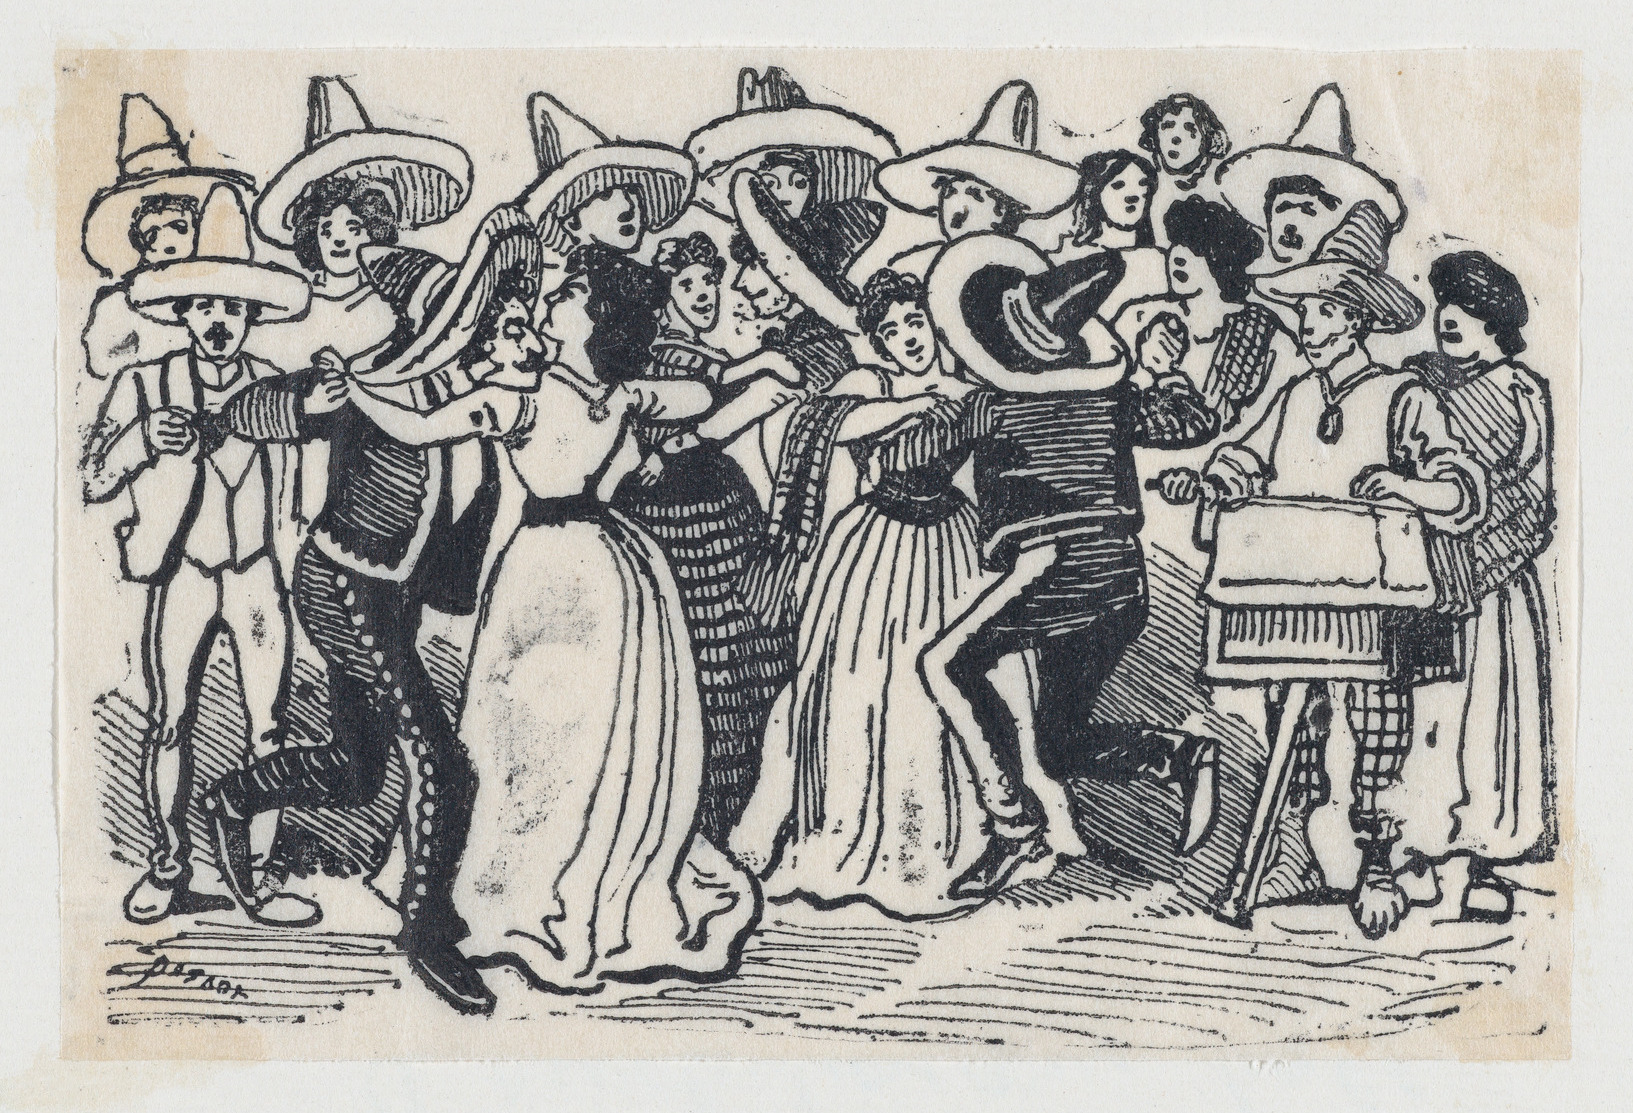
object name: print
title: A ball (scene from the Mexican Revolution)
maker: josé guadalupe posada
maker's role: artist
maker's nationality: mexican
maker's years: 1852-1913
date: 1911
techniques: lithography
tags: men,women,dancing